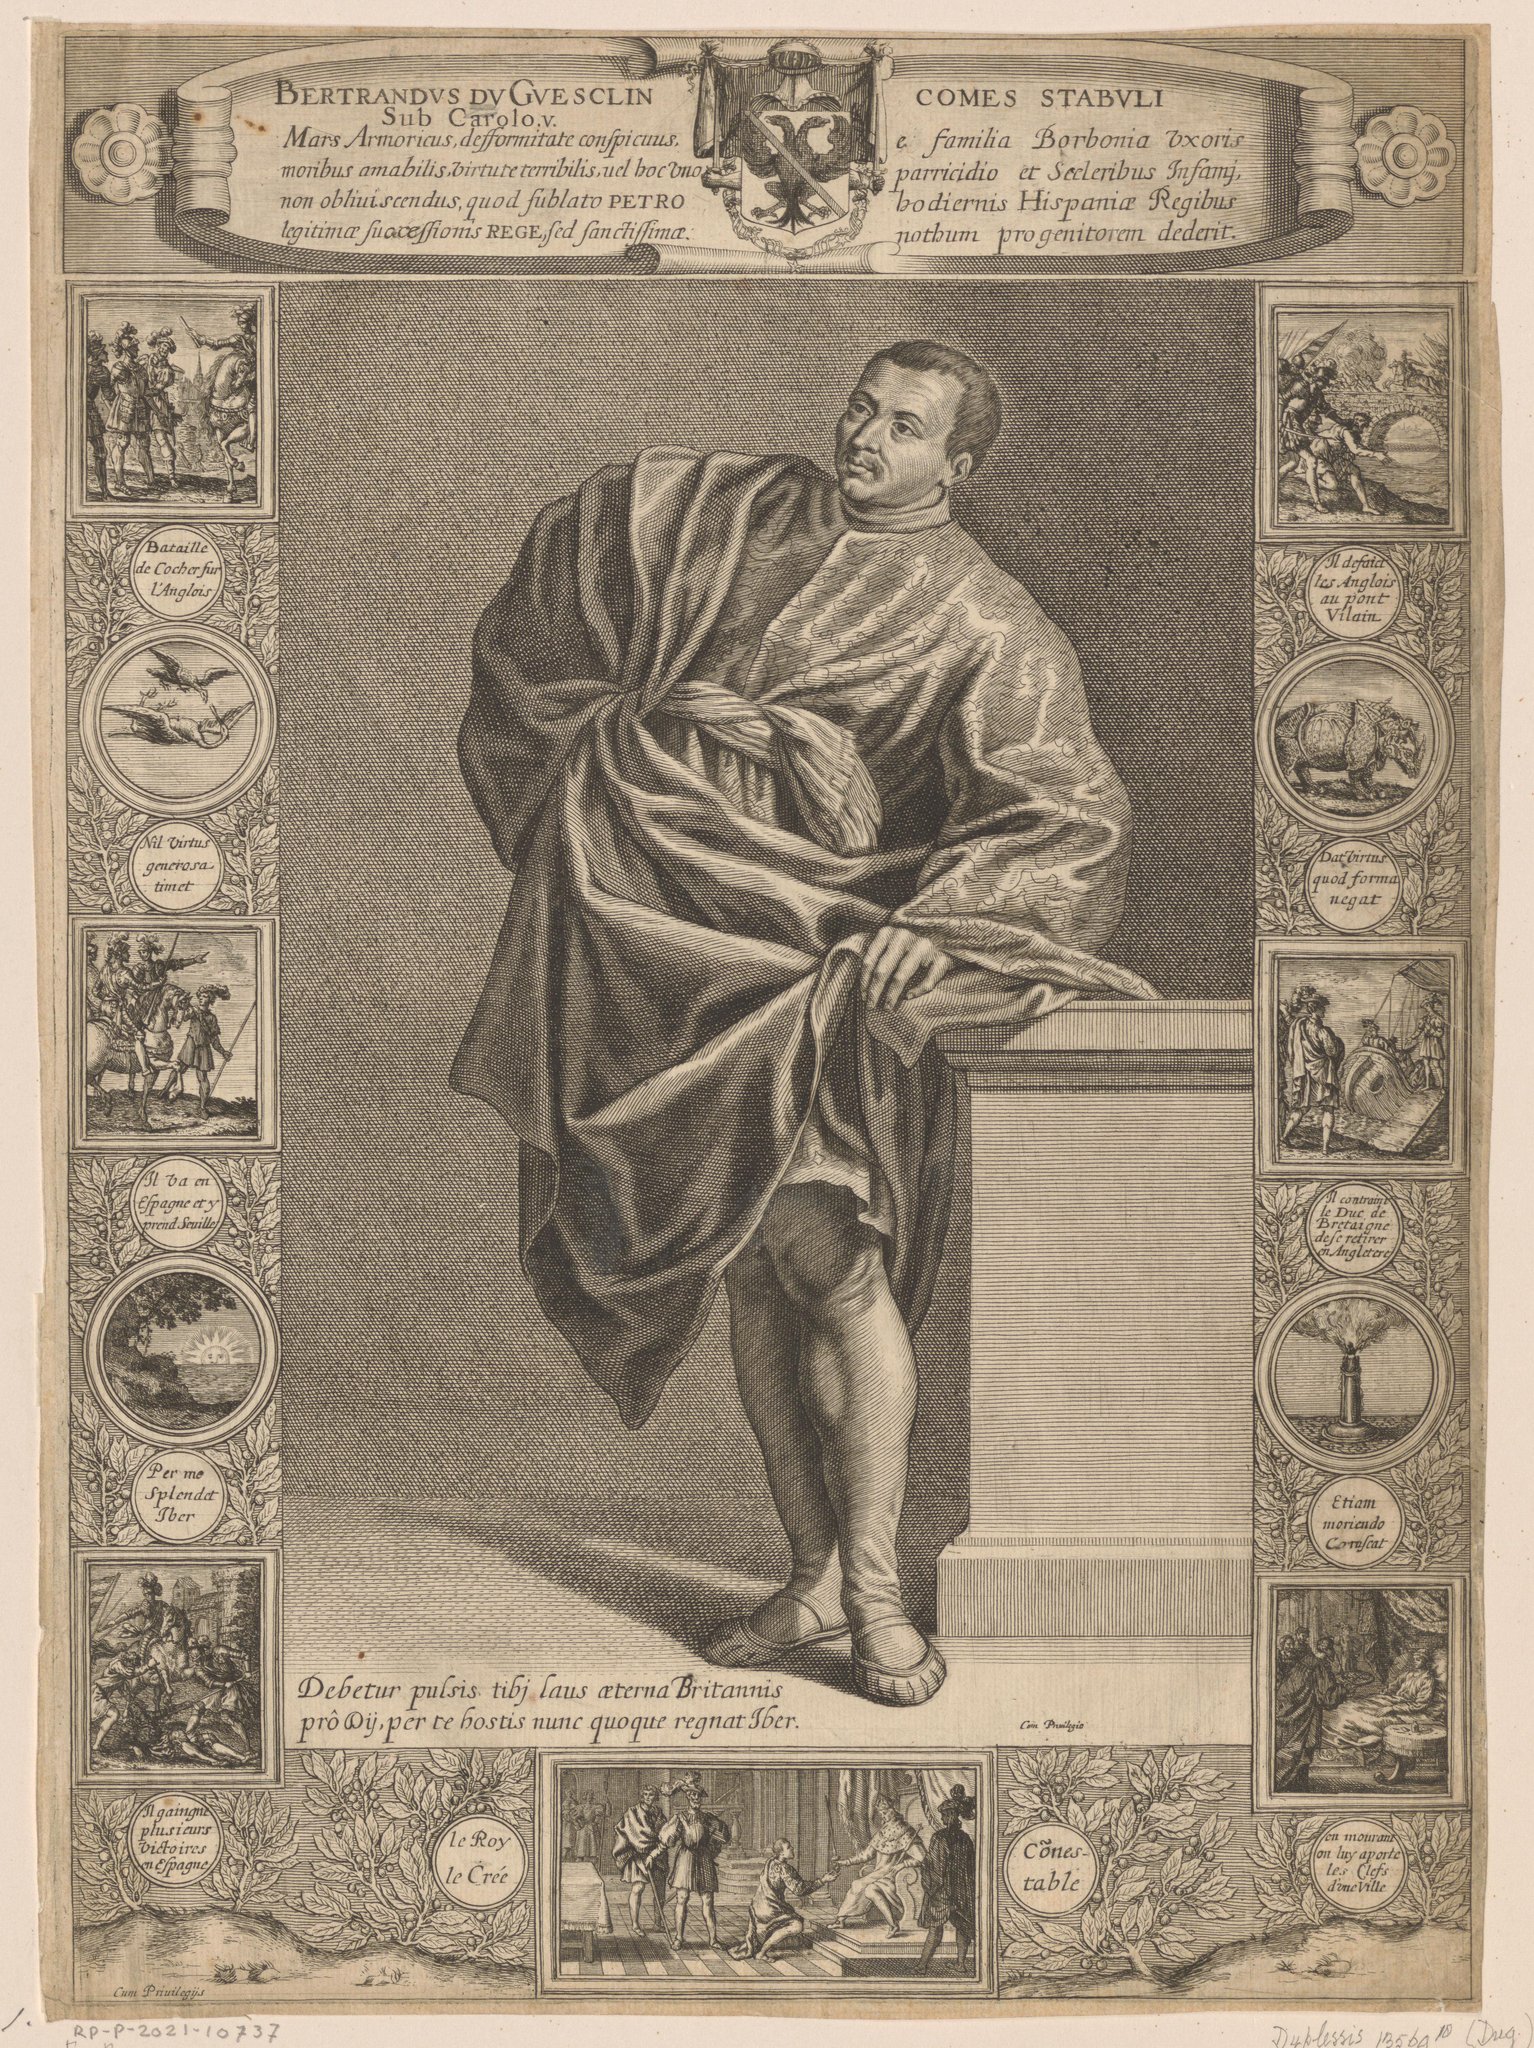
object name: print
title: Portret van Bertrand du Guesclin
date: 1650-1690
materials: paper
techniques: engraving, etching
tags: standing figure, sailing-ship, sailing-boat, birds, historical persons, battle, hoofed animals: rhinoceros, trees: olive-tree, sunset, armorial bearing, heraldry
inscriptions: collector's mark: Lugt 2228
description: Prent mogelijk uit: Vulson de La Colombière, Marc de. Les portraits des hommes illustres François qui sont peints dans la gallerie du Palais cardinal de Richelieu (...). Parijs: Henry Sara et al., 1650. Of uit latere publicaties (1655, 1662, 1690 en 1690).